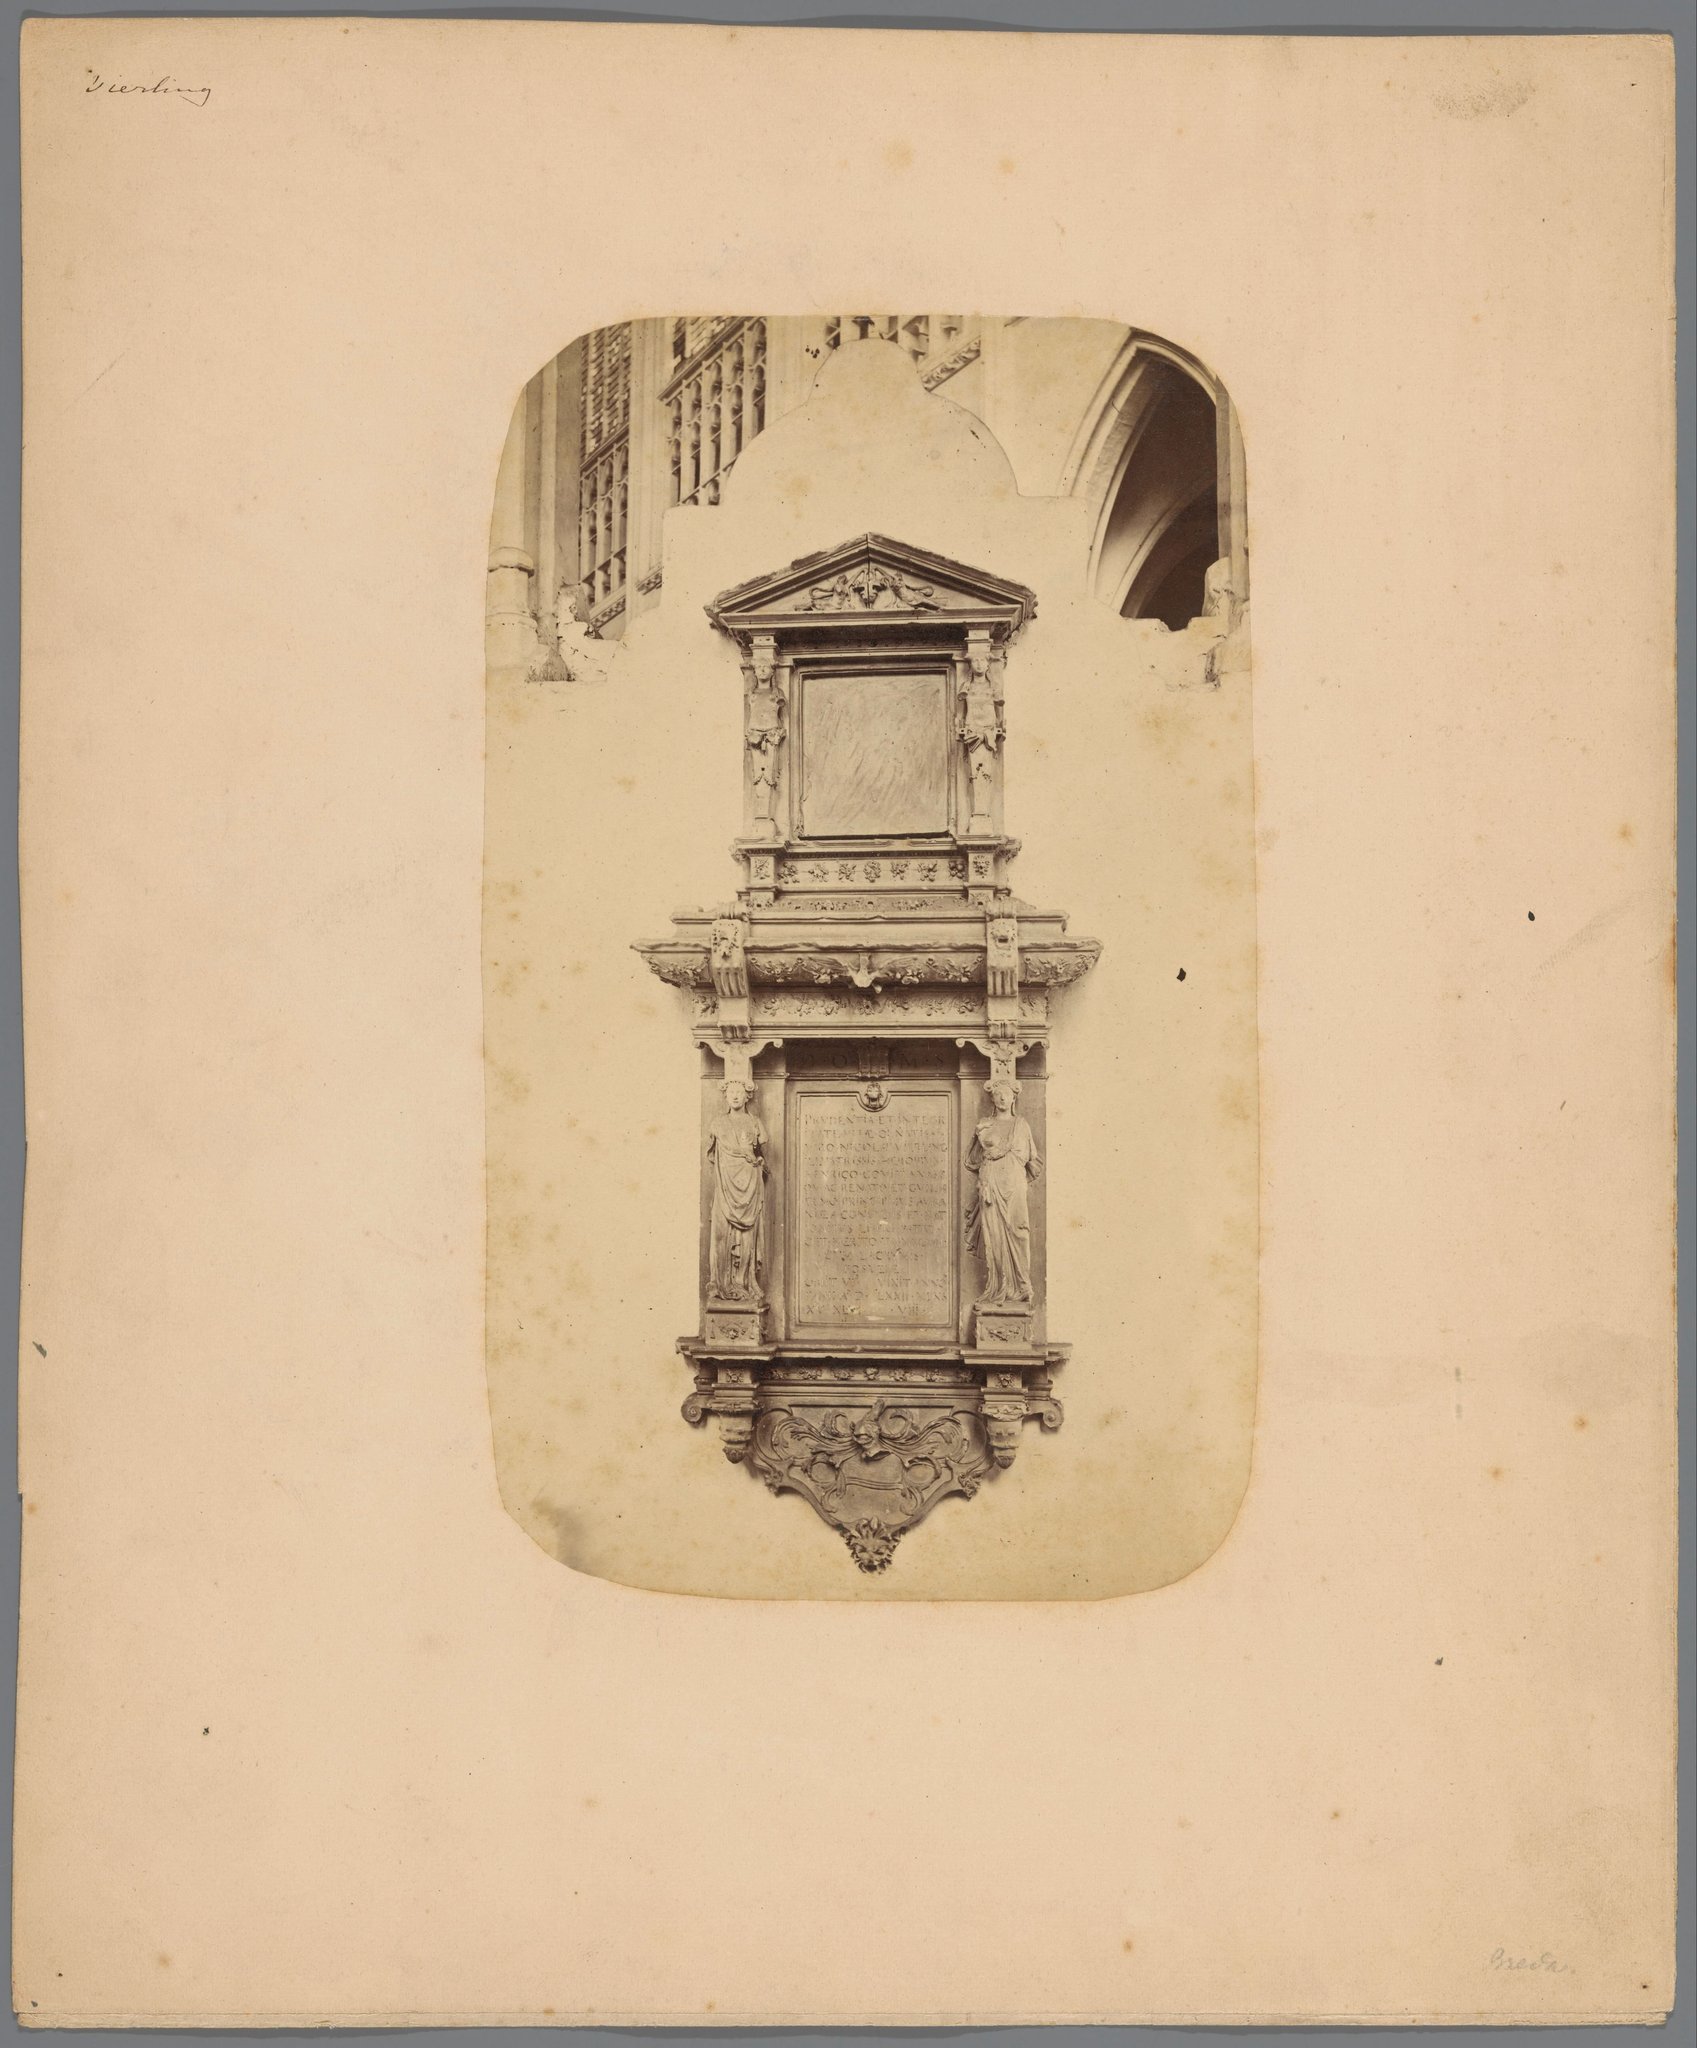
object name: photograph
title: Epitaaf voor Nicolaas Vierling in de Onze-Lieve-Vrouwekerk te Breda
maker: Anonymous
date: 1875-1900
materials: cardboard, photographic support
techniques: albumen print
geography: grote kerk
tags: caryatids ~ architecture, interior of church, epitaph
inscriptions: name: ‘S. FRANCO, b.i. den Haag.’, inscription: ‘Breda.’, inscription: ‘Vierling’